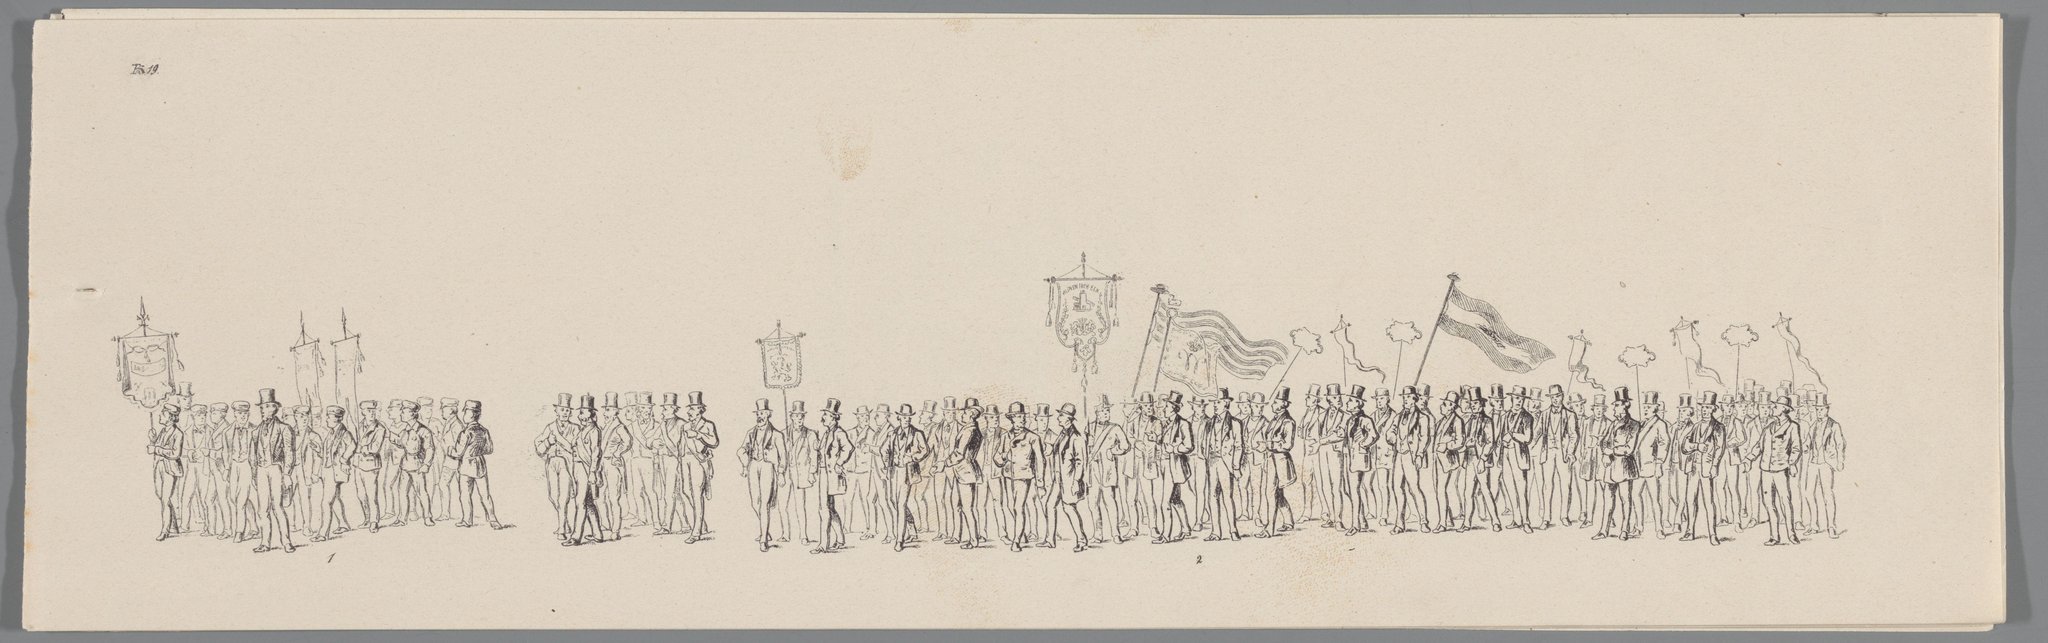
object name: print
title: Plaat 19. - Fig. 1. De Ambachtsschool van de Maatschappij voor den Werkenden stand (...) de Vereeniging: "Velen en toch één"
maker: Anonymous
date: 1874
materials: paper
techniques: lithograph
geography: netherlands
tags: brussels, willem iii (koning der nederlanden), public festivities at other royal events, not meant or mentioned above (+ parade, pageant, cavalcade ~ festive activities), modern professional organization, trade union, amsterdam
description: Plaat nr. 19 met het deel van de optocht met leden van twee vakvereniginegen, waaronder de Ambachtsschool van de Maatschappij voor den Werkenden Stand. Onderdeel van een serie van 24 platen van de gekostumeerde historische en allegorische optocht gehouden te Amsterdam op 12 mei 1874, als onderdeel van de feestelijkheden tijdens de viering van het 25-jarige regeringsjubileum van koning Willem III.